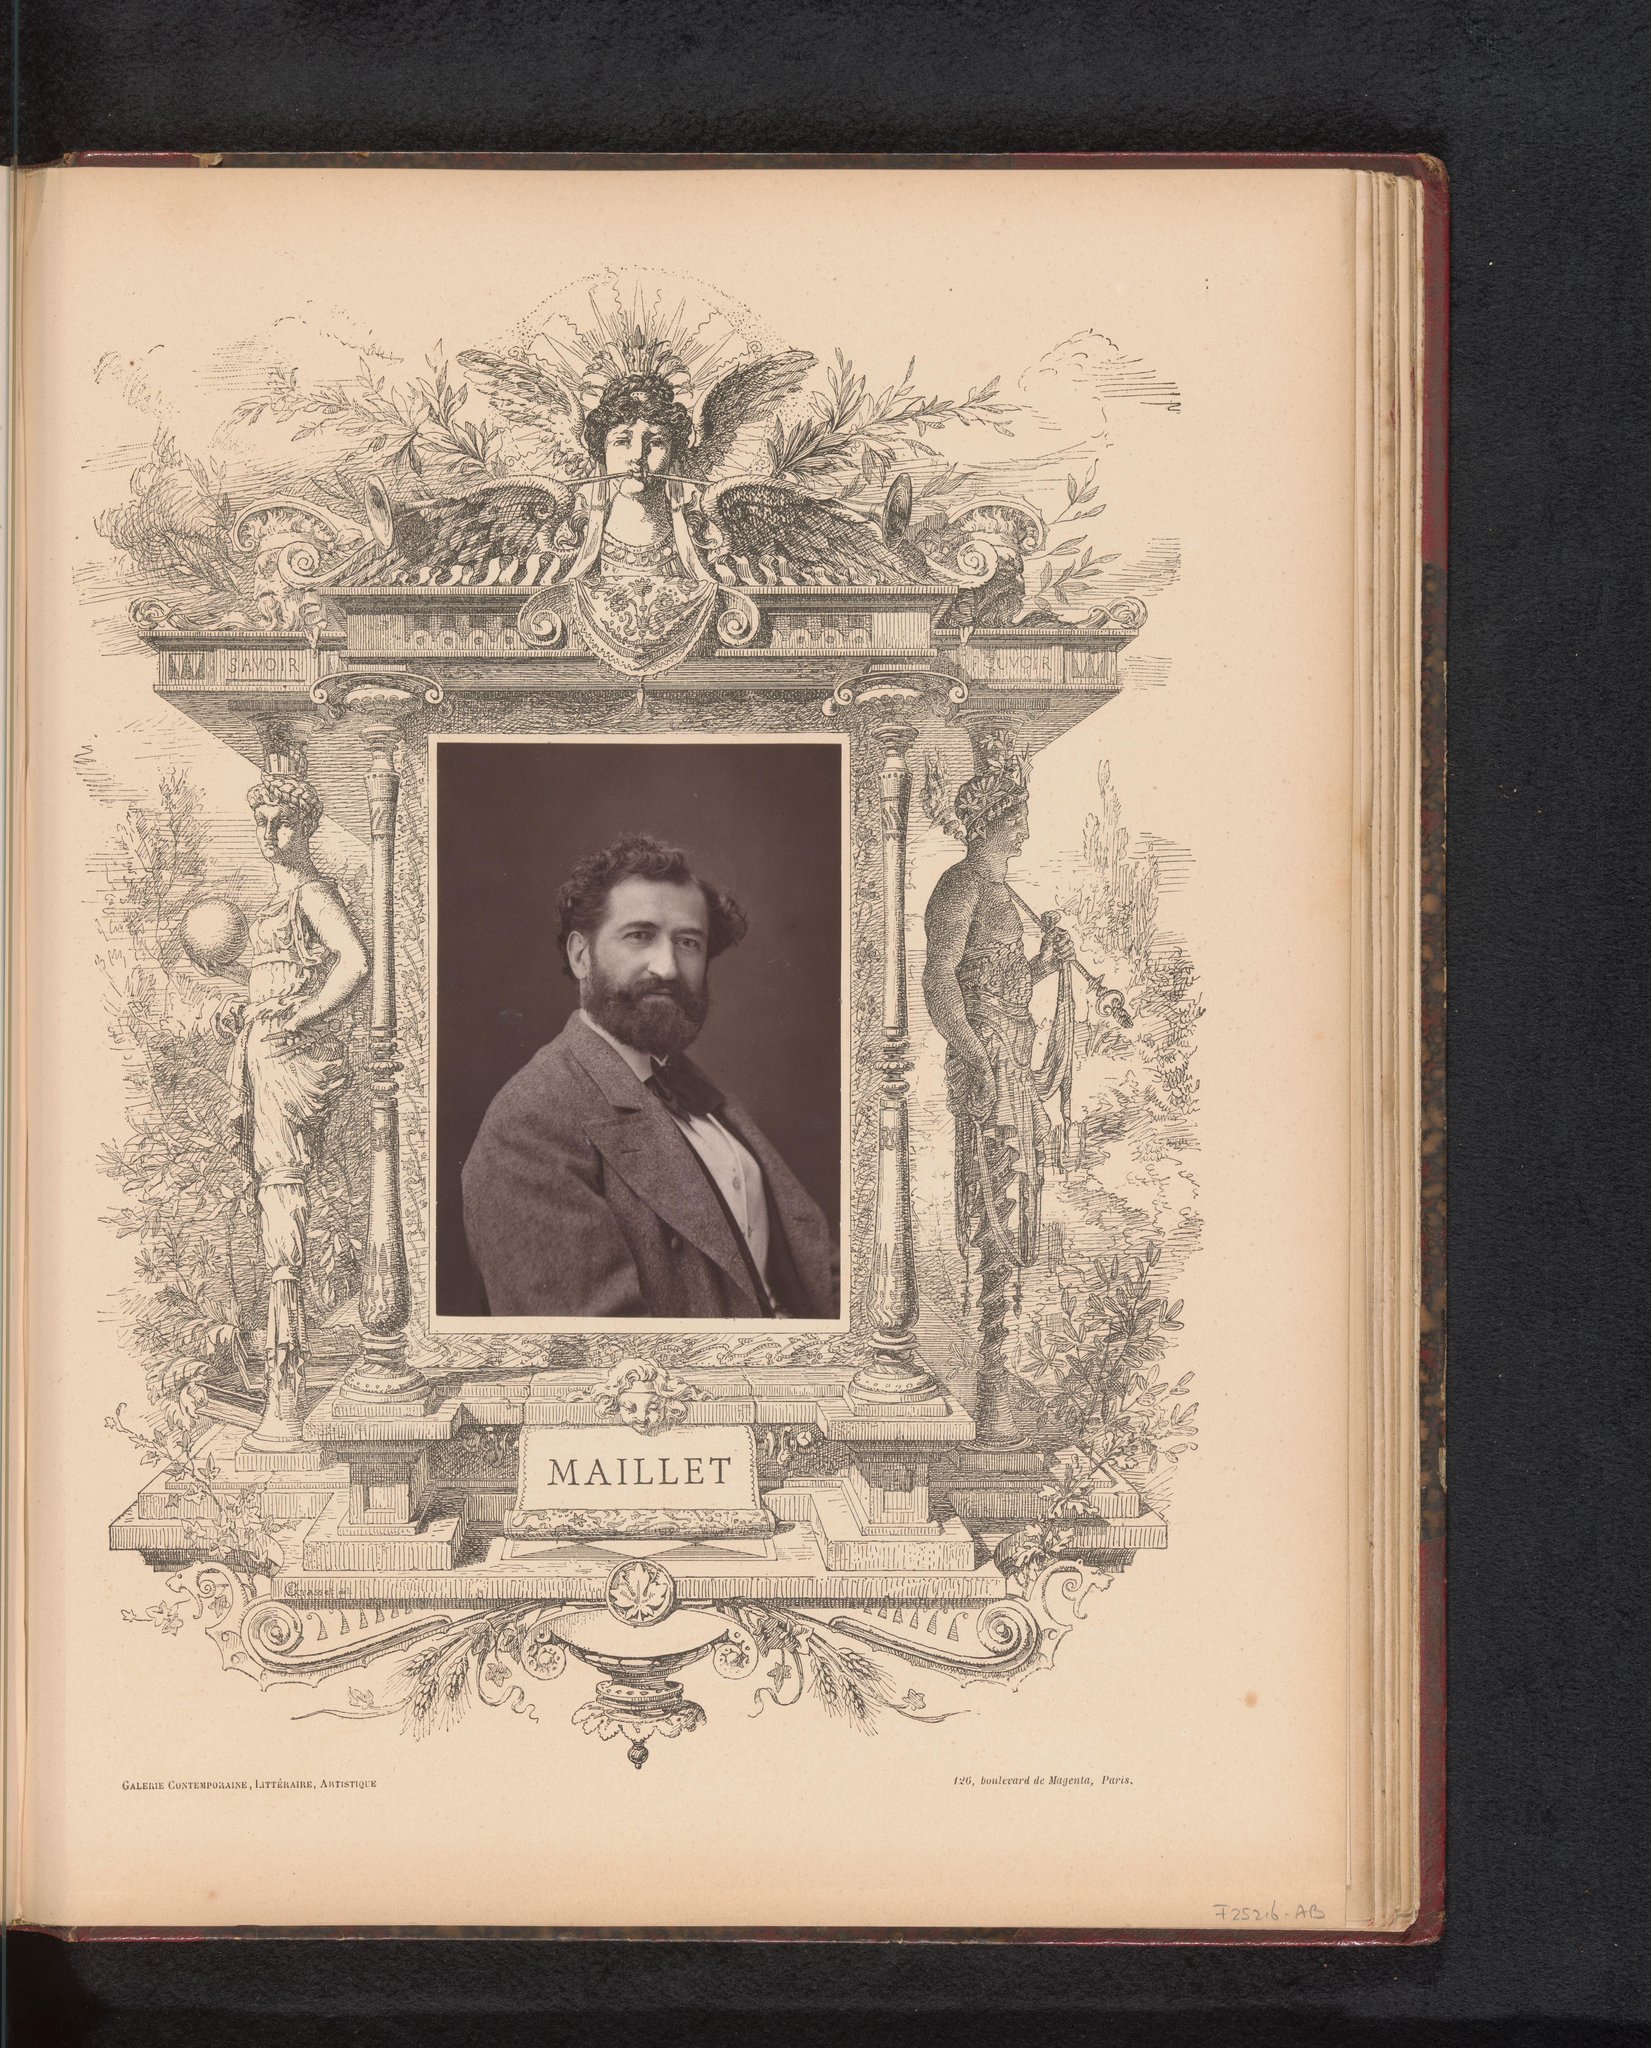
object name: page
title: Maillet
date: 1871-1876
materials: paper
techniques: printing block, woodburytype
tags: paris, sculptor, jacques-léonard maillet, adult man, historical persons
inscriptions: inscription: ‘Galerie Contemporaine, Littéraire, Artistique/ 126, boulevard de Magenta, Paris’